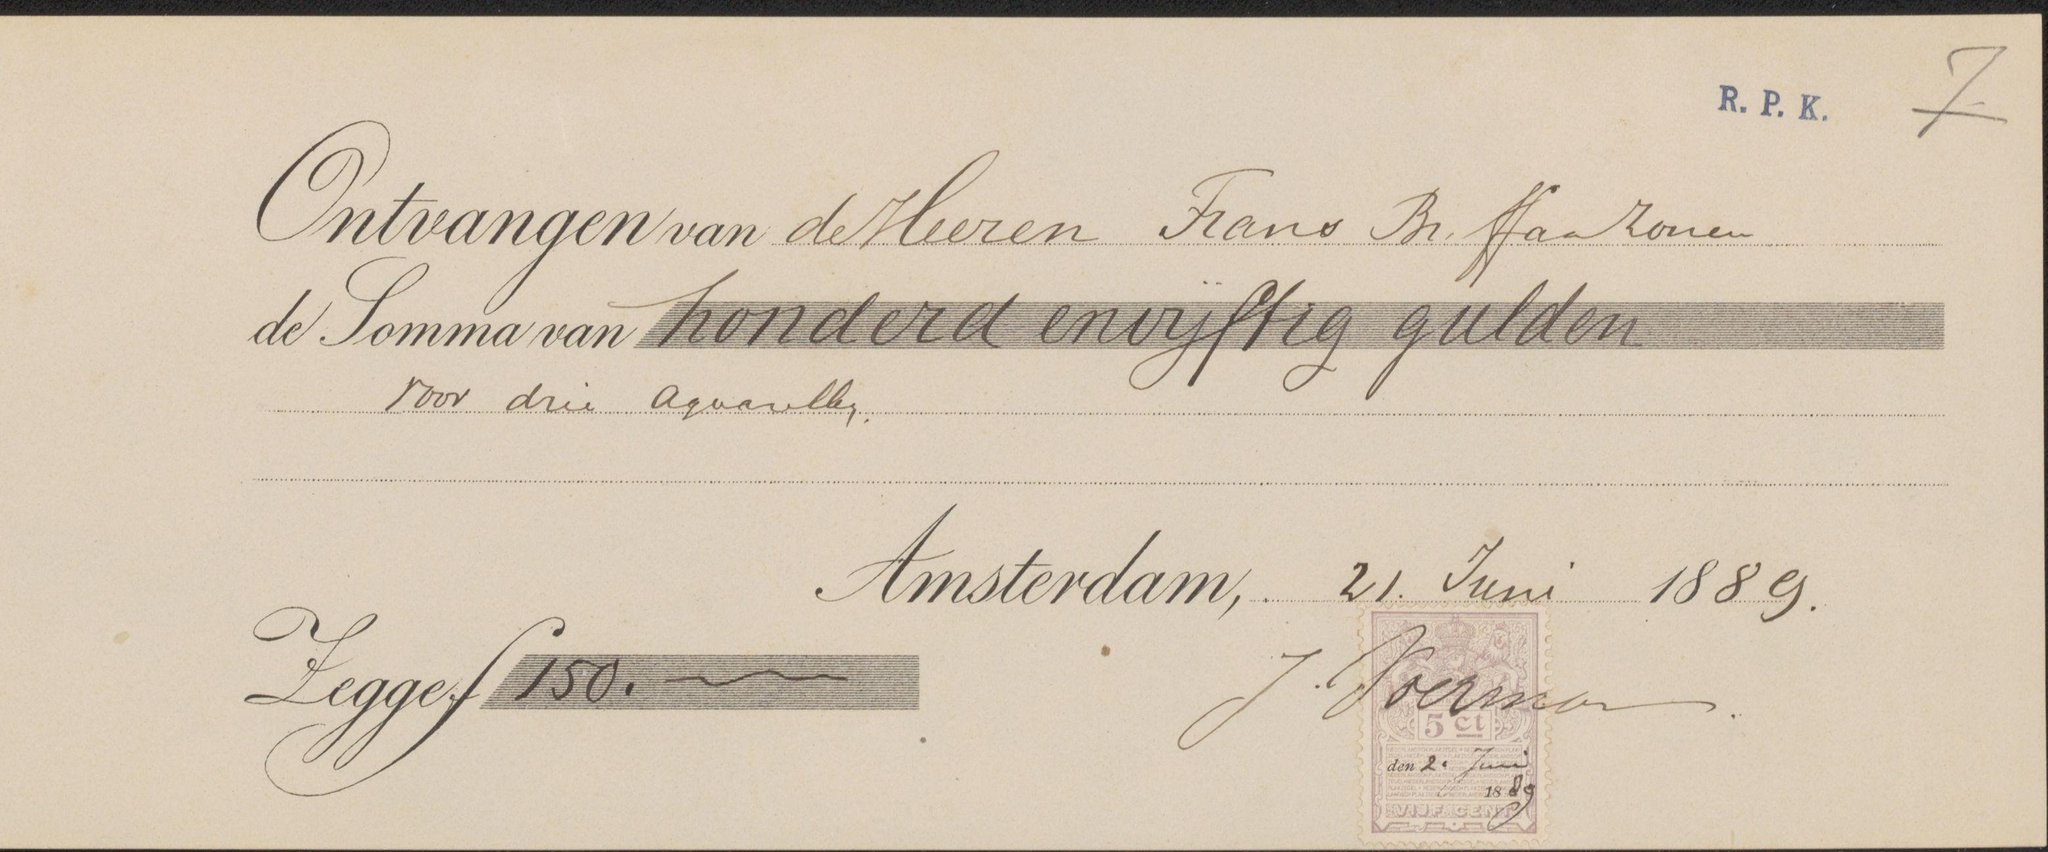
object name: ontvangstbewijs, kwitantie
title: Kwitantie voor Jan Voerman (1857-1941)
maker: jan voerman (1857-1941)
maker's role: draughtsman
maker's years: 1857-1941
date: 1889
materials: ink, paper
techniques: pen, printing, writing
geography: amsterdam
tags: drawing, money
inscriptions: collector's mark: Lugt 2233